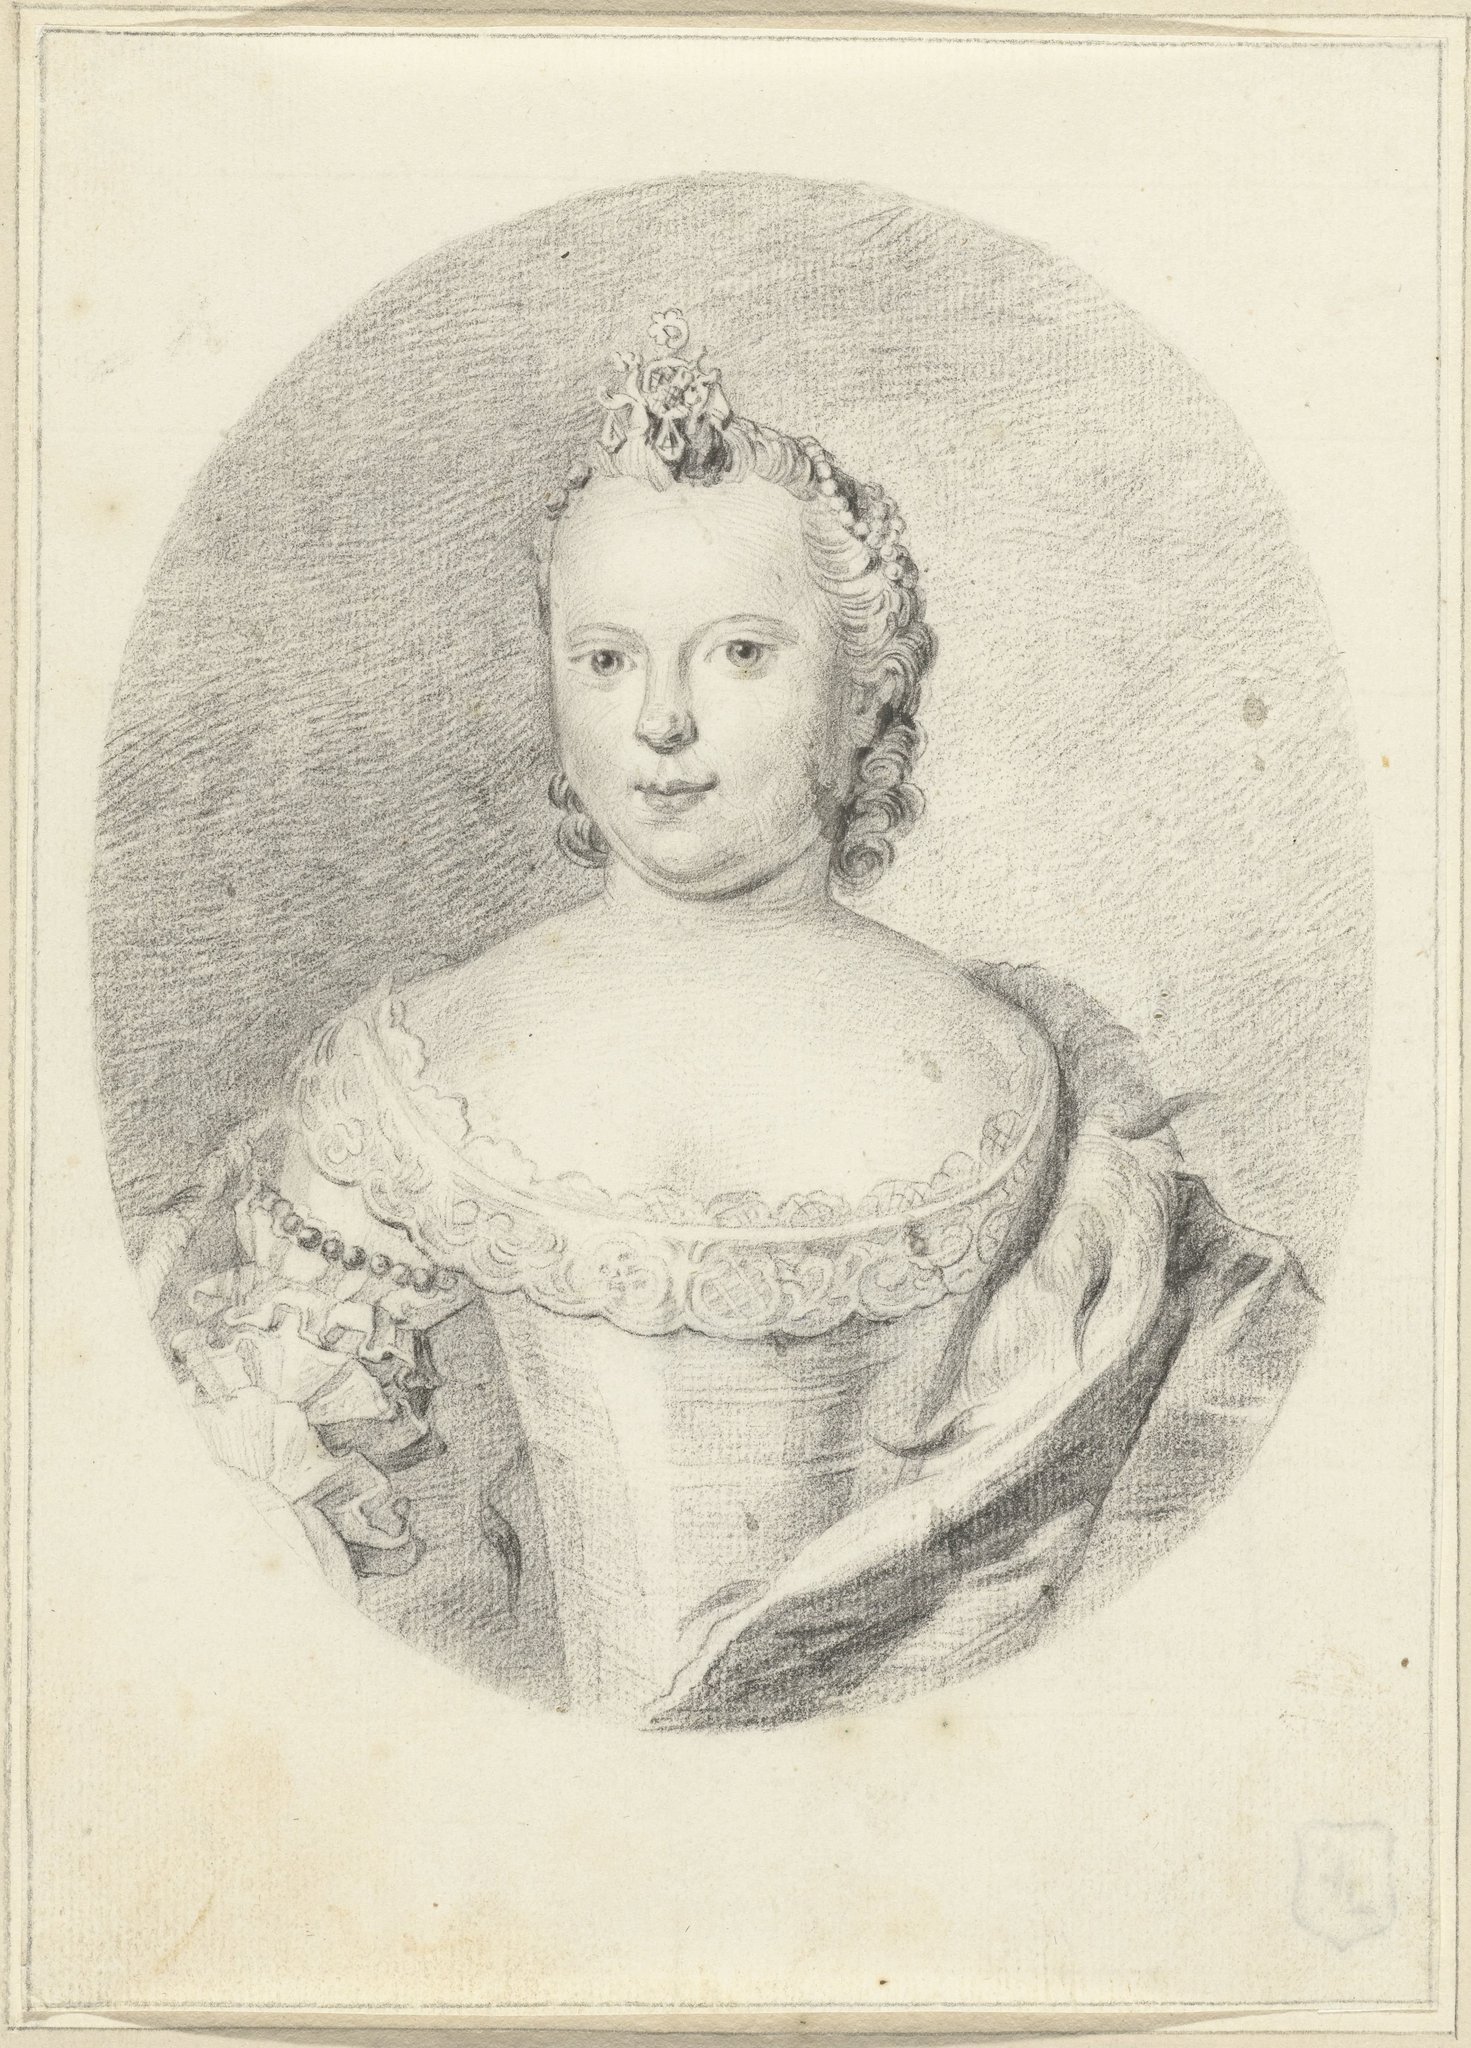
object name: drawing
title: Portret van Carolina, prinses van Oranje-Nassau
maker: hendrik pothoven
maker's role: draughtsman, painter, print maker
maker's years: 1725-1807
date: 1735-1807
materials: chalk, paper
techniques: brush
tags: carolina (prinses van oranje-nassau), historical persons